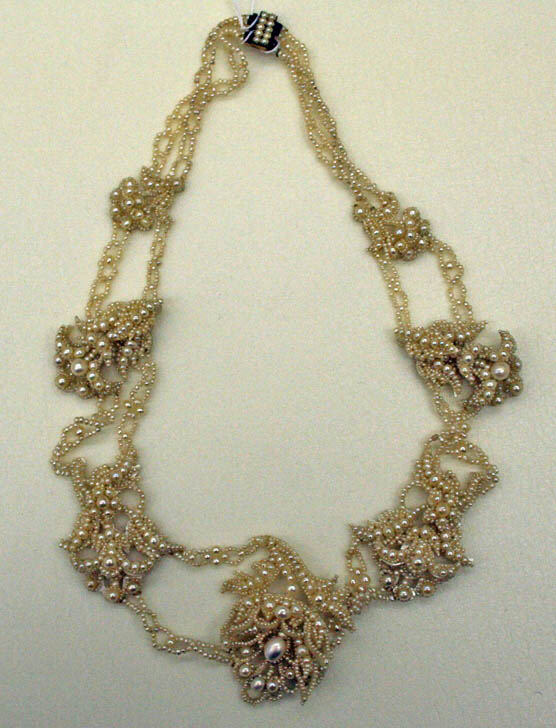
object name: jewelry set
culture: european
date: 1860-1865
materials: pearl